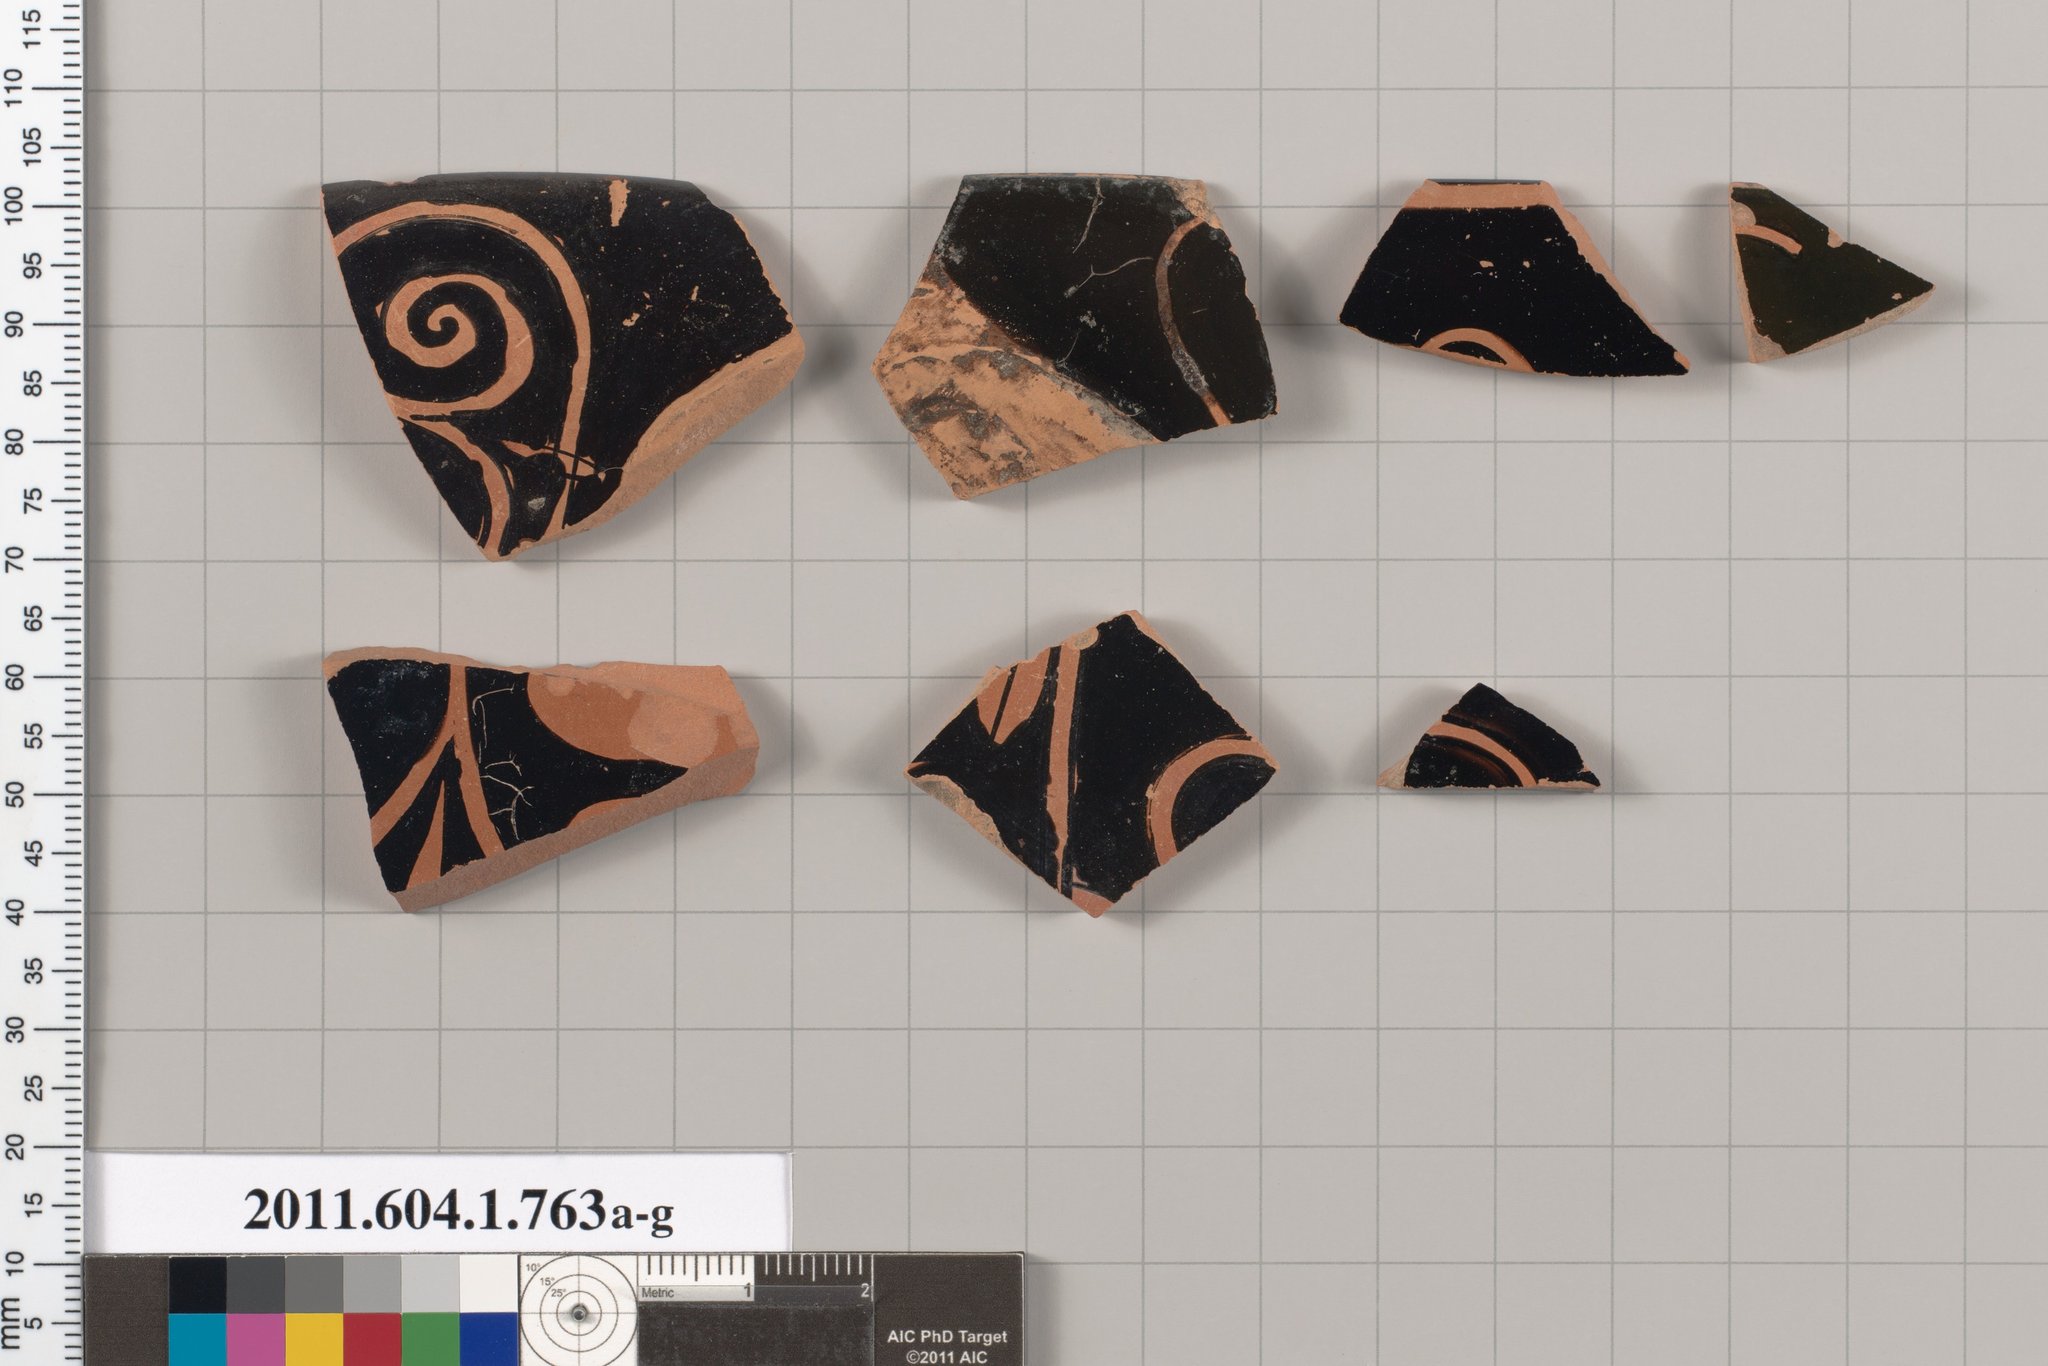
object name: kylix fragment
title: Terracotta rim fragments of kylikes (drinking cups)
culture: greek, attic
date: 475-451 BCE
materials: terracotta